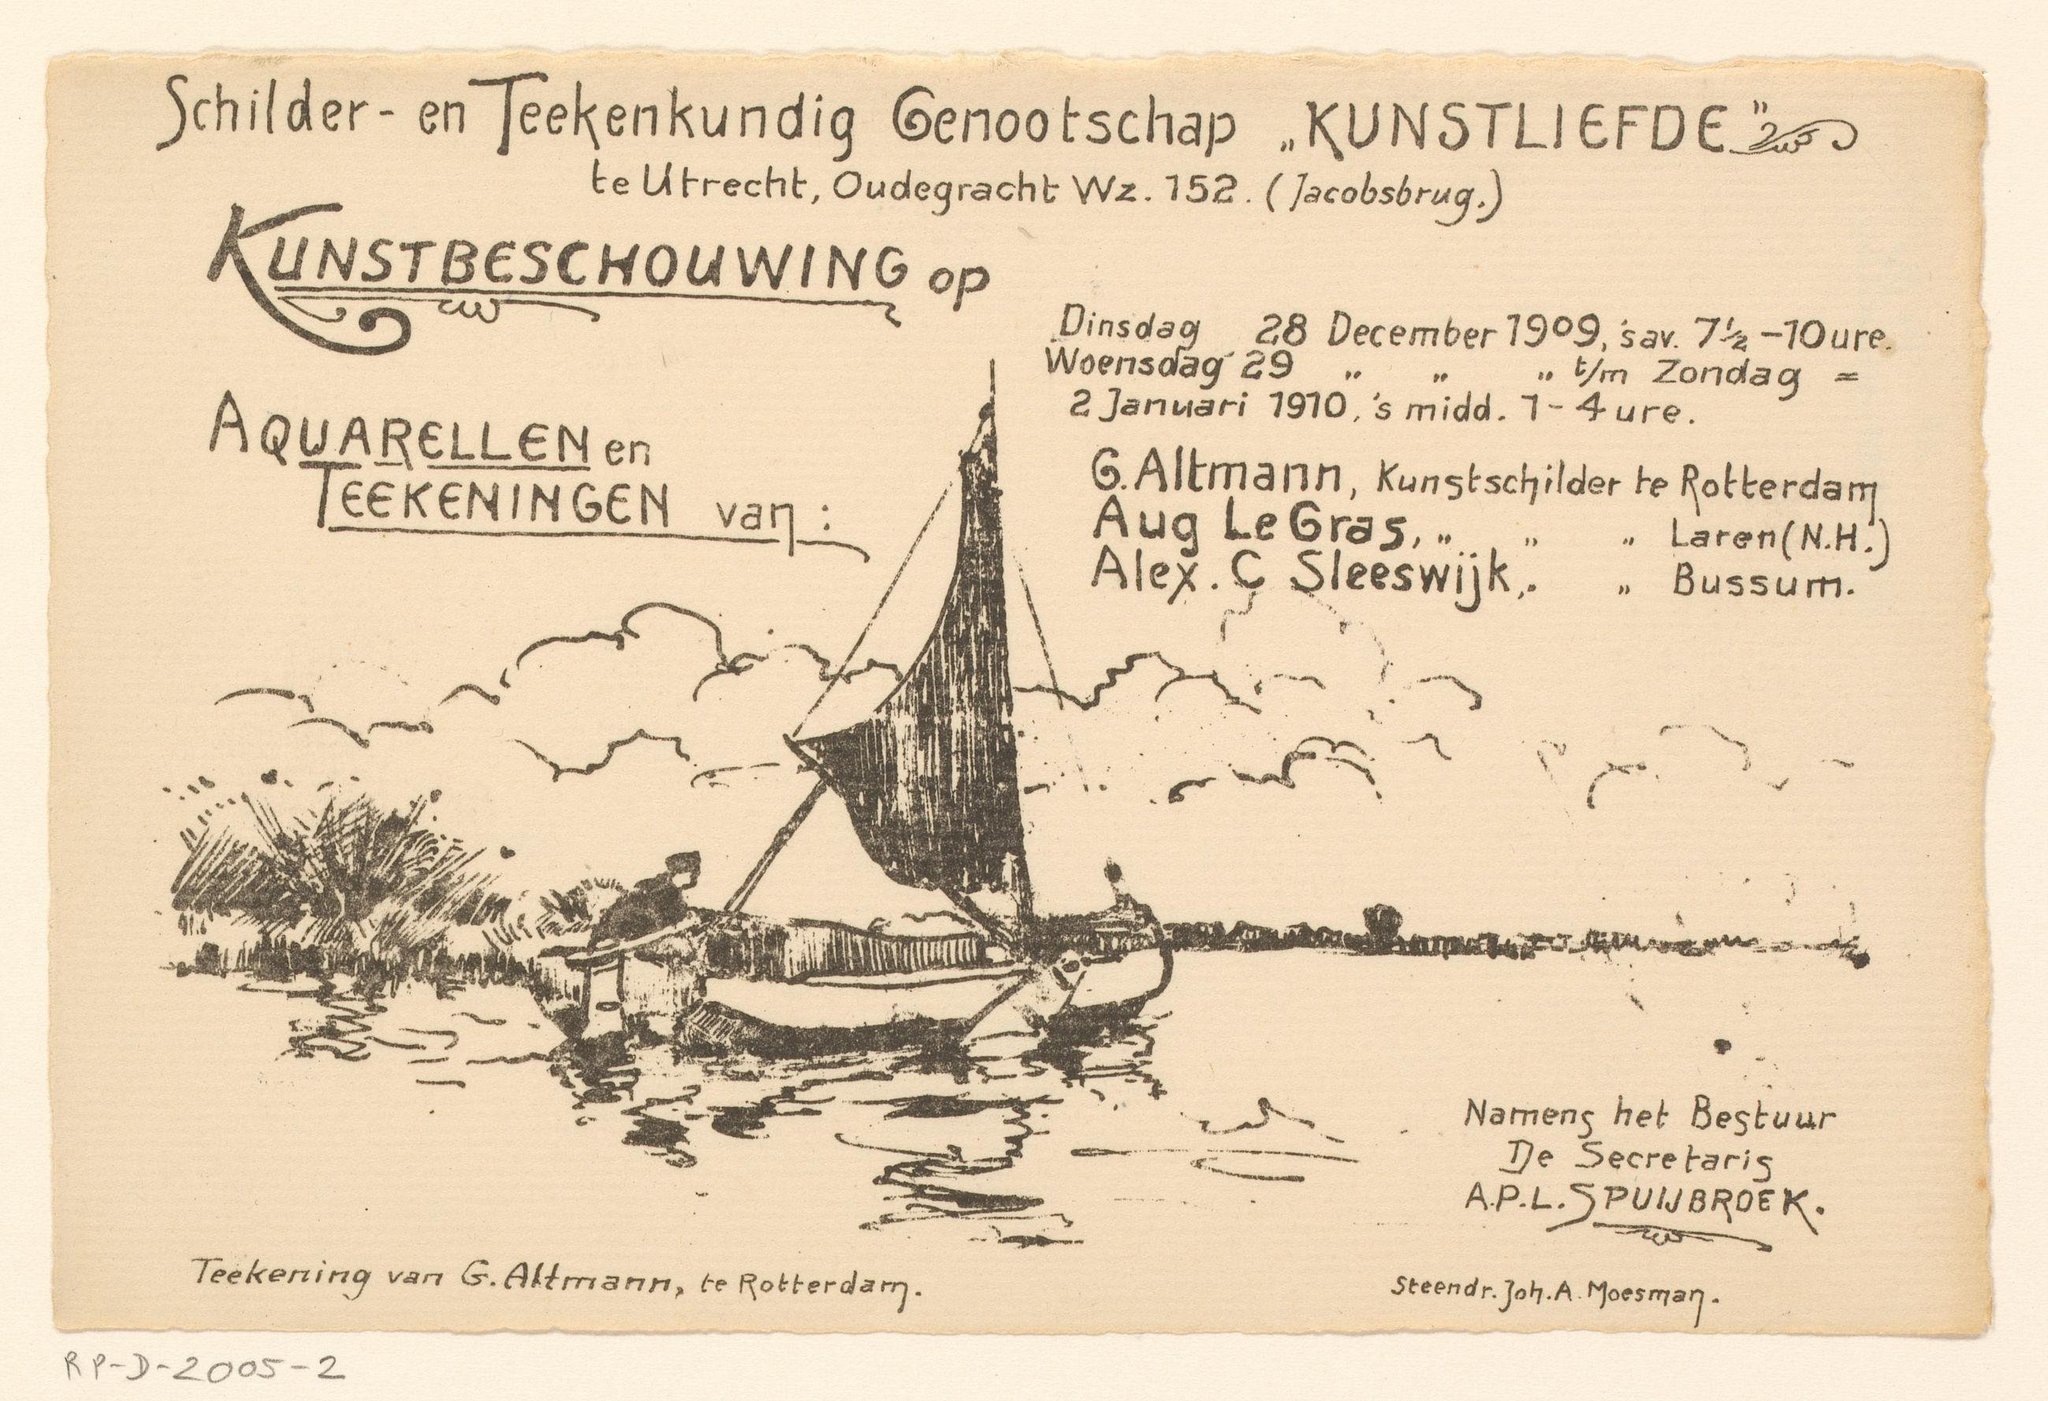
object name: print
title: Uitnodiging van Schilder- en Teekenkundig Genootschap "Kunstliefde" voor een kunstbeschouwing, 28 december 1909 - 2 januari 1910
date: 1909-1912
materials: paper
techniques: lithograph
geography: utrecht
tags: criticizing and discussing art, art criticism, circle, club of artists, collecting and exhibiting products of the fine arts, sailing-ship, sailing-boat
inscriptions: collector's mark: Lugt 2228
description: Zeilboot. Uitnodiging van Schilder- en Teekenkundig Genootschap "Kunstliefde" voor een kunstbeschouwing op 28 december 1909 - 2 januari 1910 van het werk van de kunstschilders G. Altmann, Aug. LeGras en Alex. C. Sleeswijk.